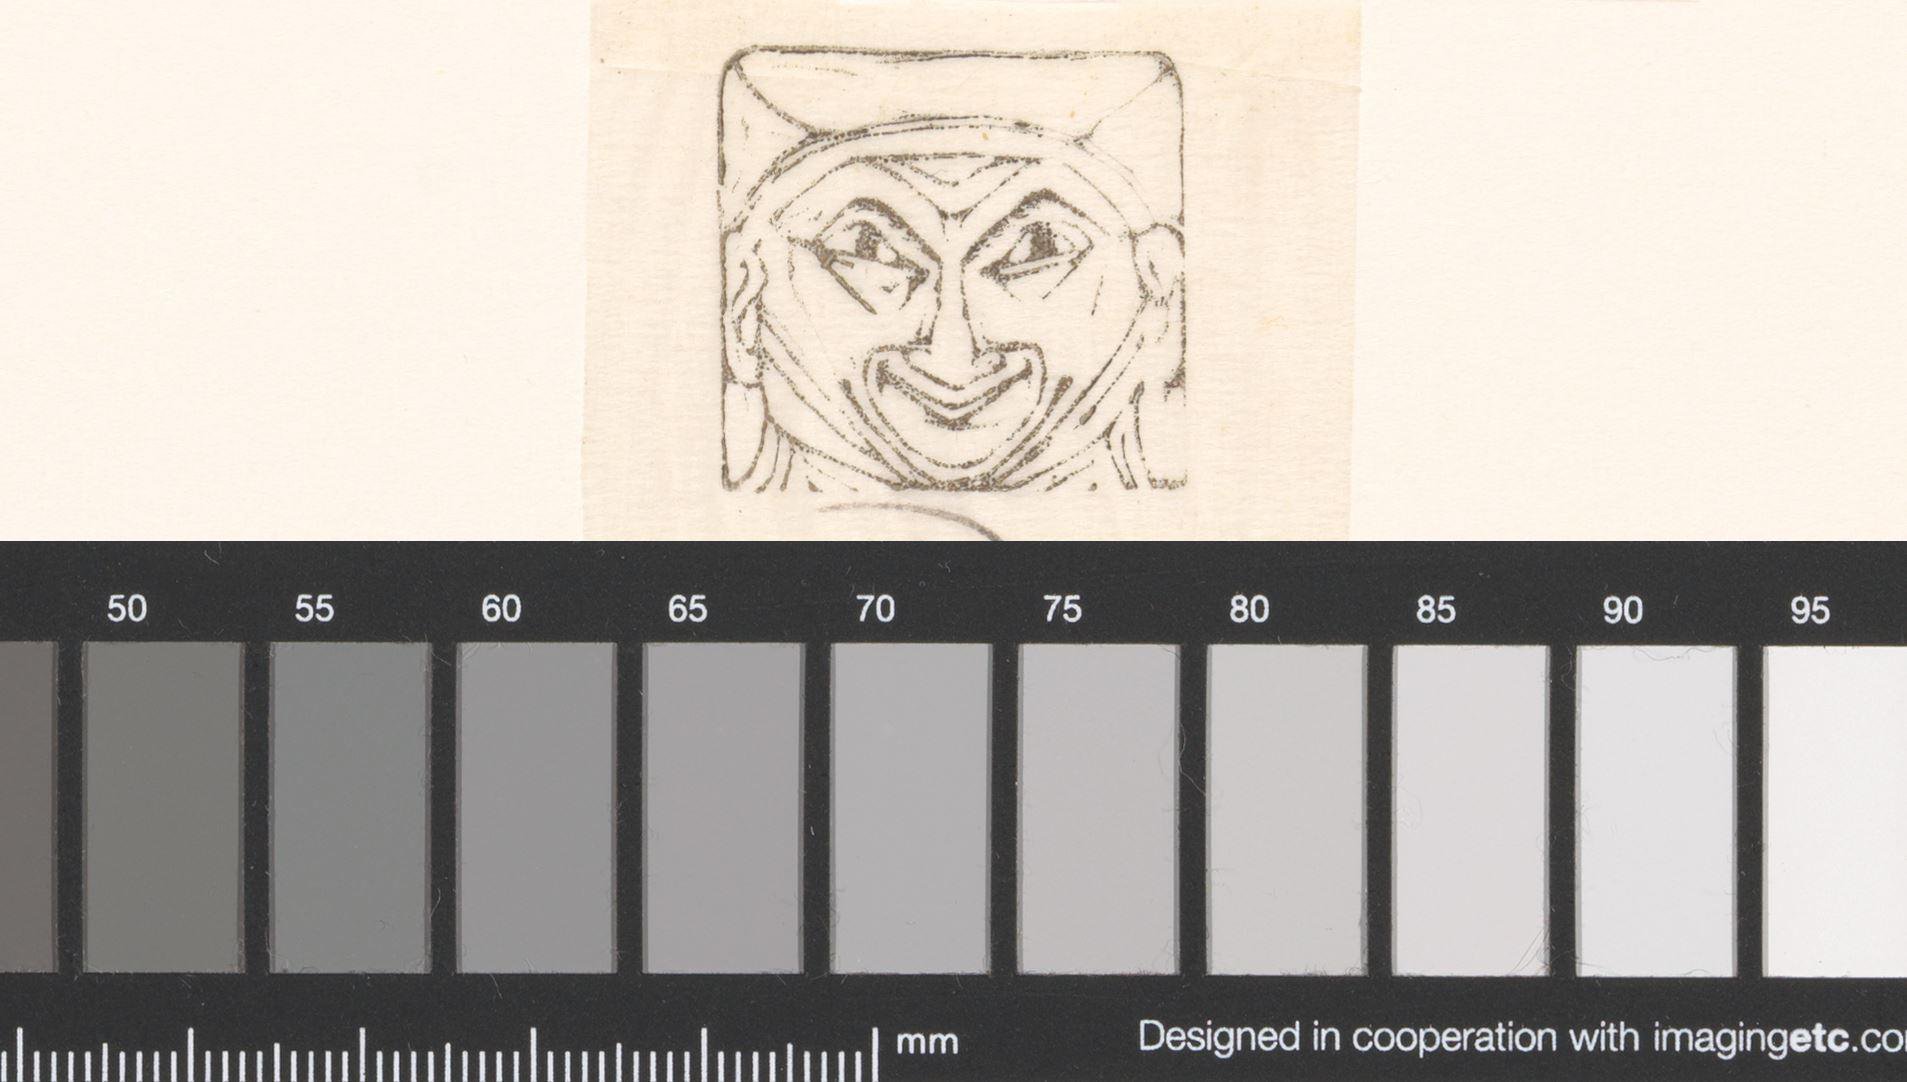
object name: vignette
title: Vignet met masker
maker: mathieu lauweriks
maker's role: designer, draughtsman, print maker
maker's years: 1864-1932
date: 1895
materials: paper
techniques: woodcut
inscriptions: collector's mark: Lugt 2228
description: Prent mogelijk gebruikt voor: Licht en waarheid. Orgaan van de vereeniging 'Wie Denkt Overwint'. Amsterdam: Wie Denkt Overwint, 12 oktober 1895.